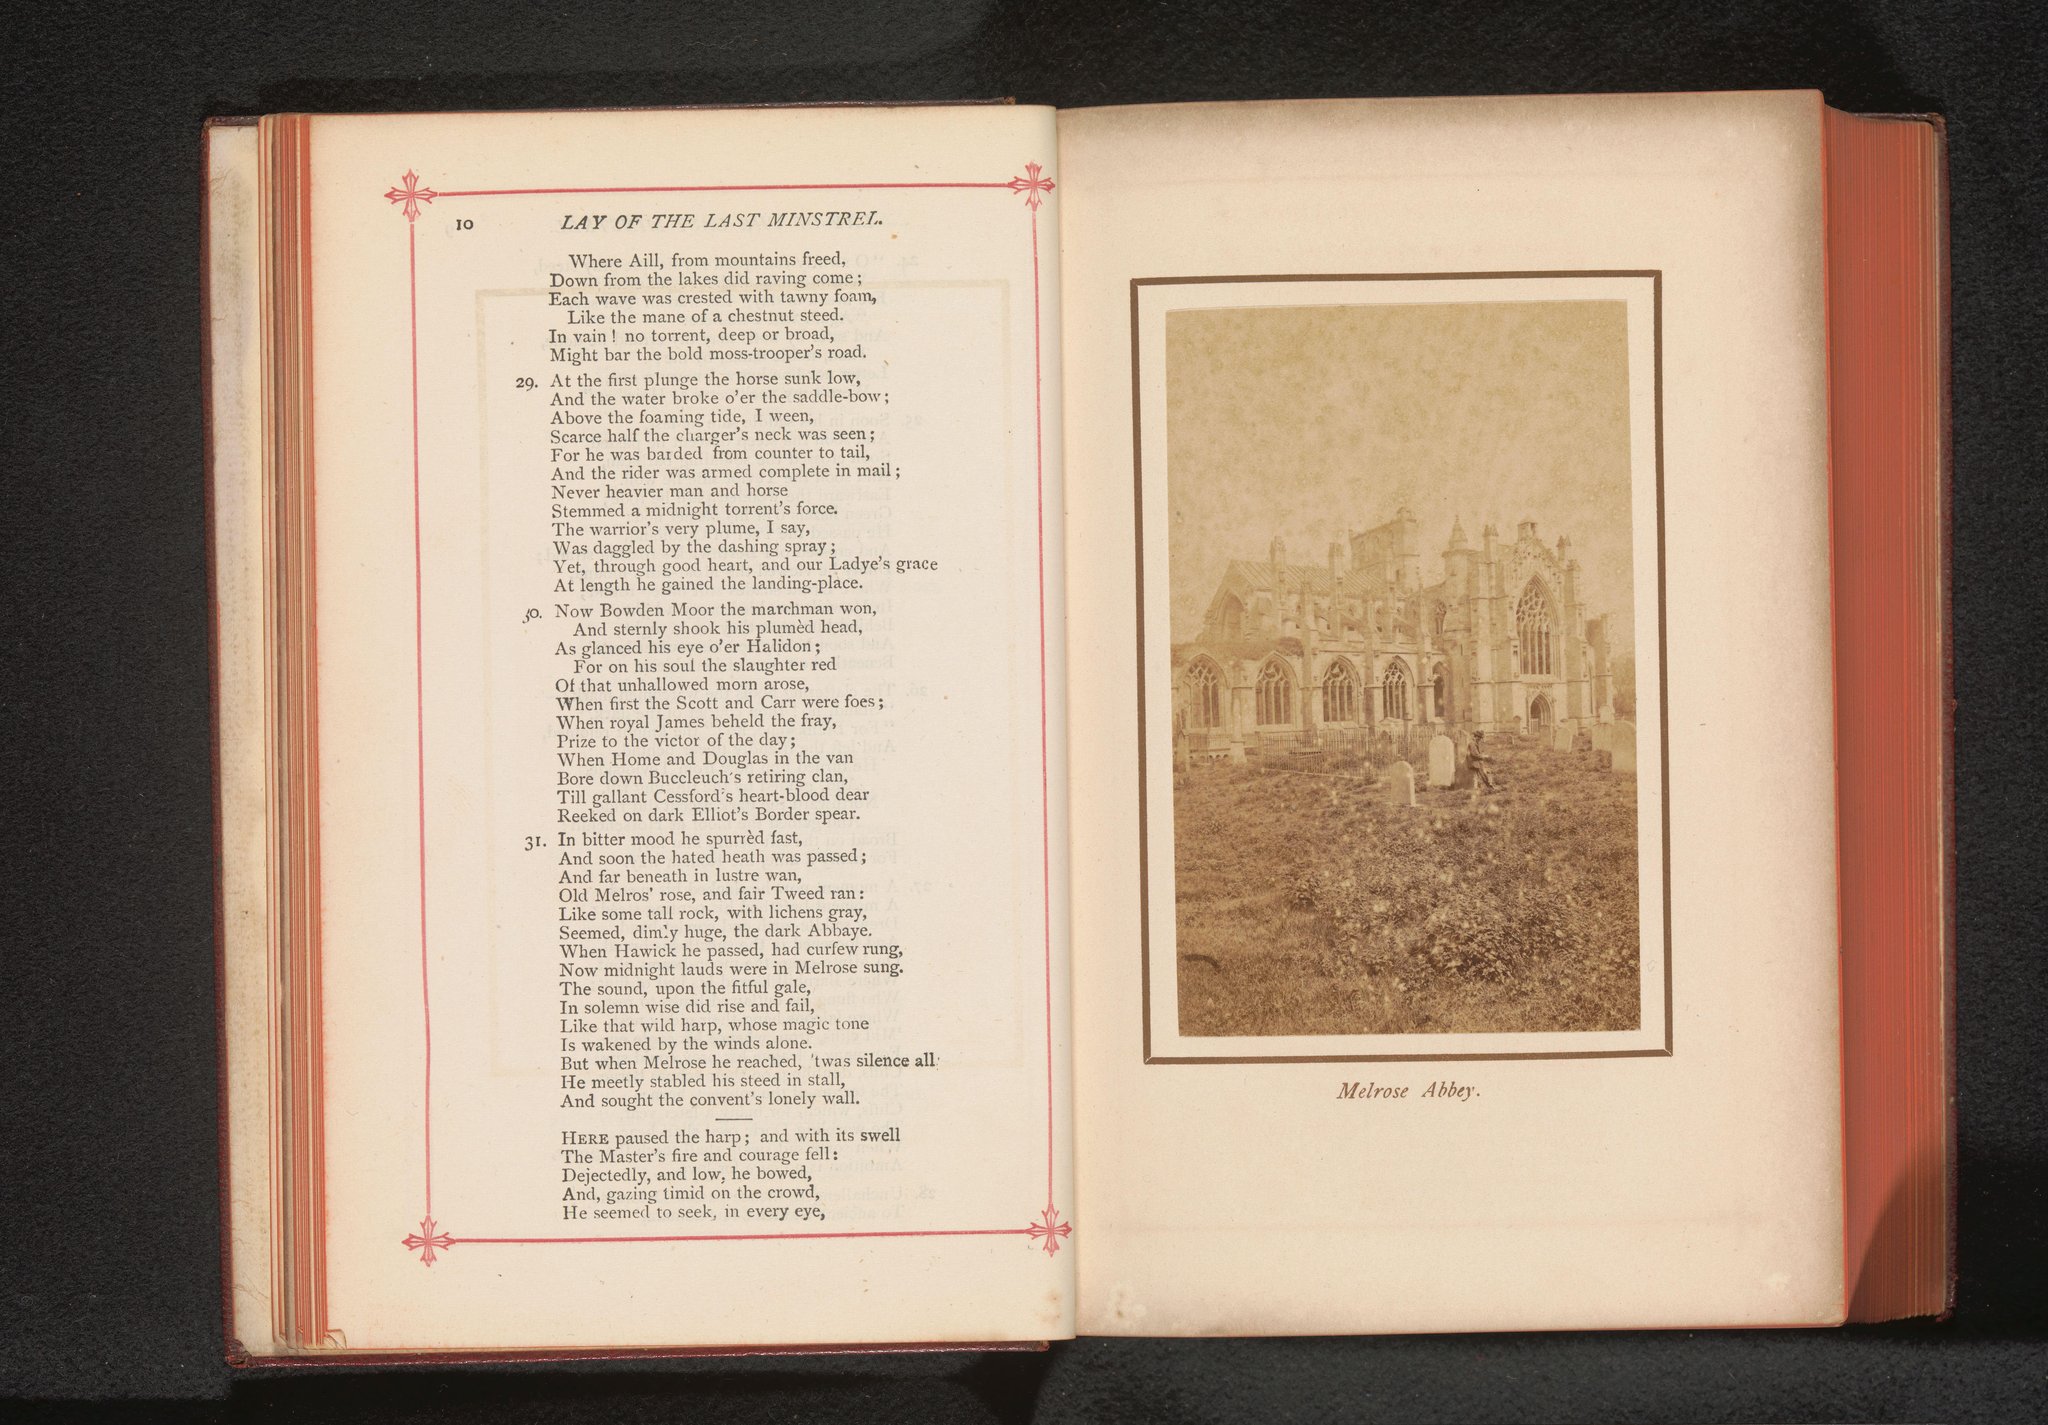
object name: photograph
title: Melrose Abbey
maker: george washington wilson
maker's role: publisher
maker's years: 1823-1893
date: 1885-1890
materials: photographic support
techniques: albumen print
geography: scotland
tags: ruin of church, monastery, etc.